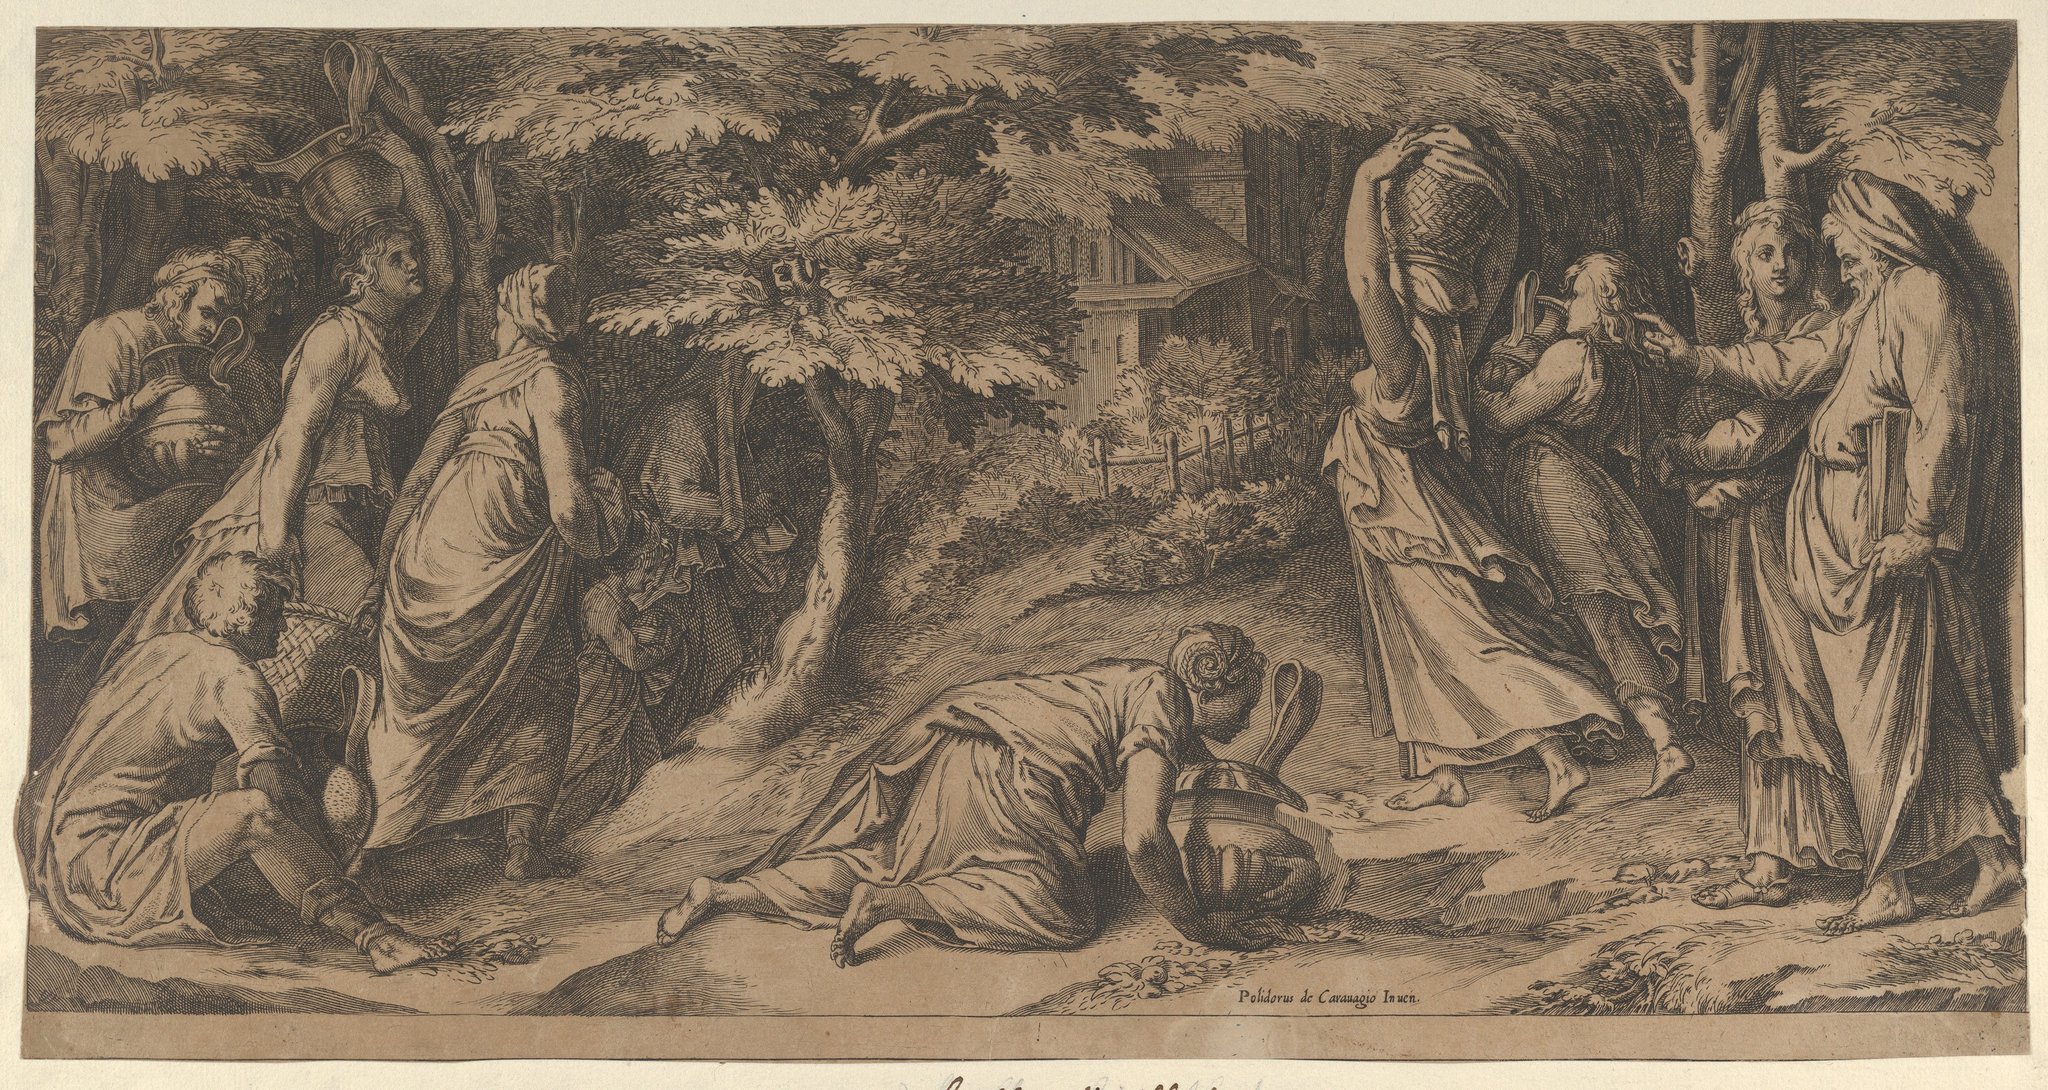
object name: print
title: The Israelites fleeing Egypt with Moses at right extending his right hand and with a woman carrying an urn prostrate before him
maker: cherubino alberti (zaccaria mattia)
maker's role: artist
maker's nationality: italian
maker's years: 1553-1615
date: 1576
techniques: engraving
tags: men,women,moses